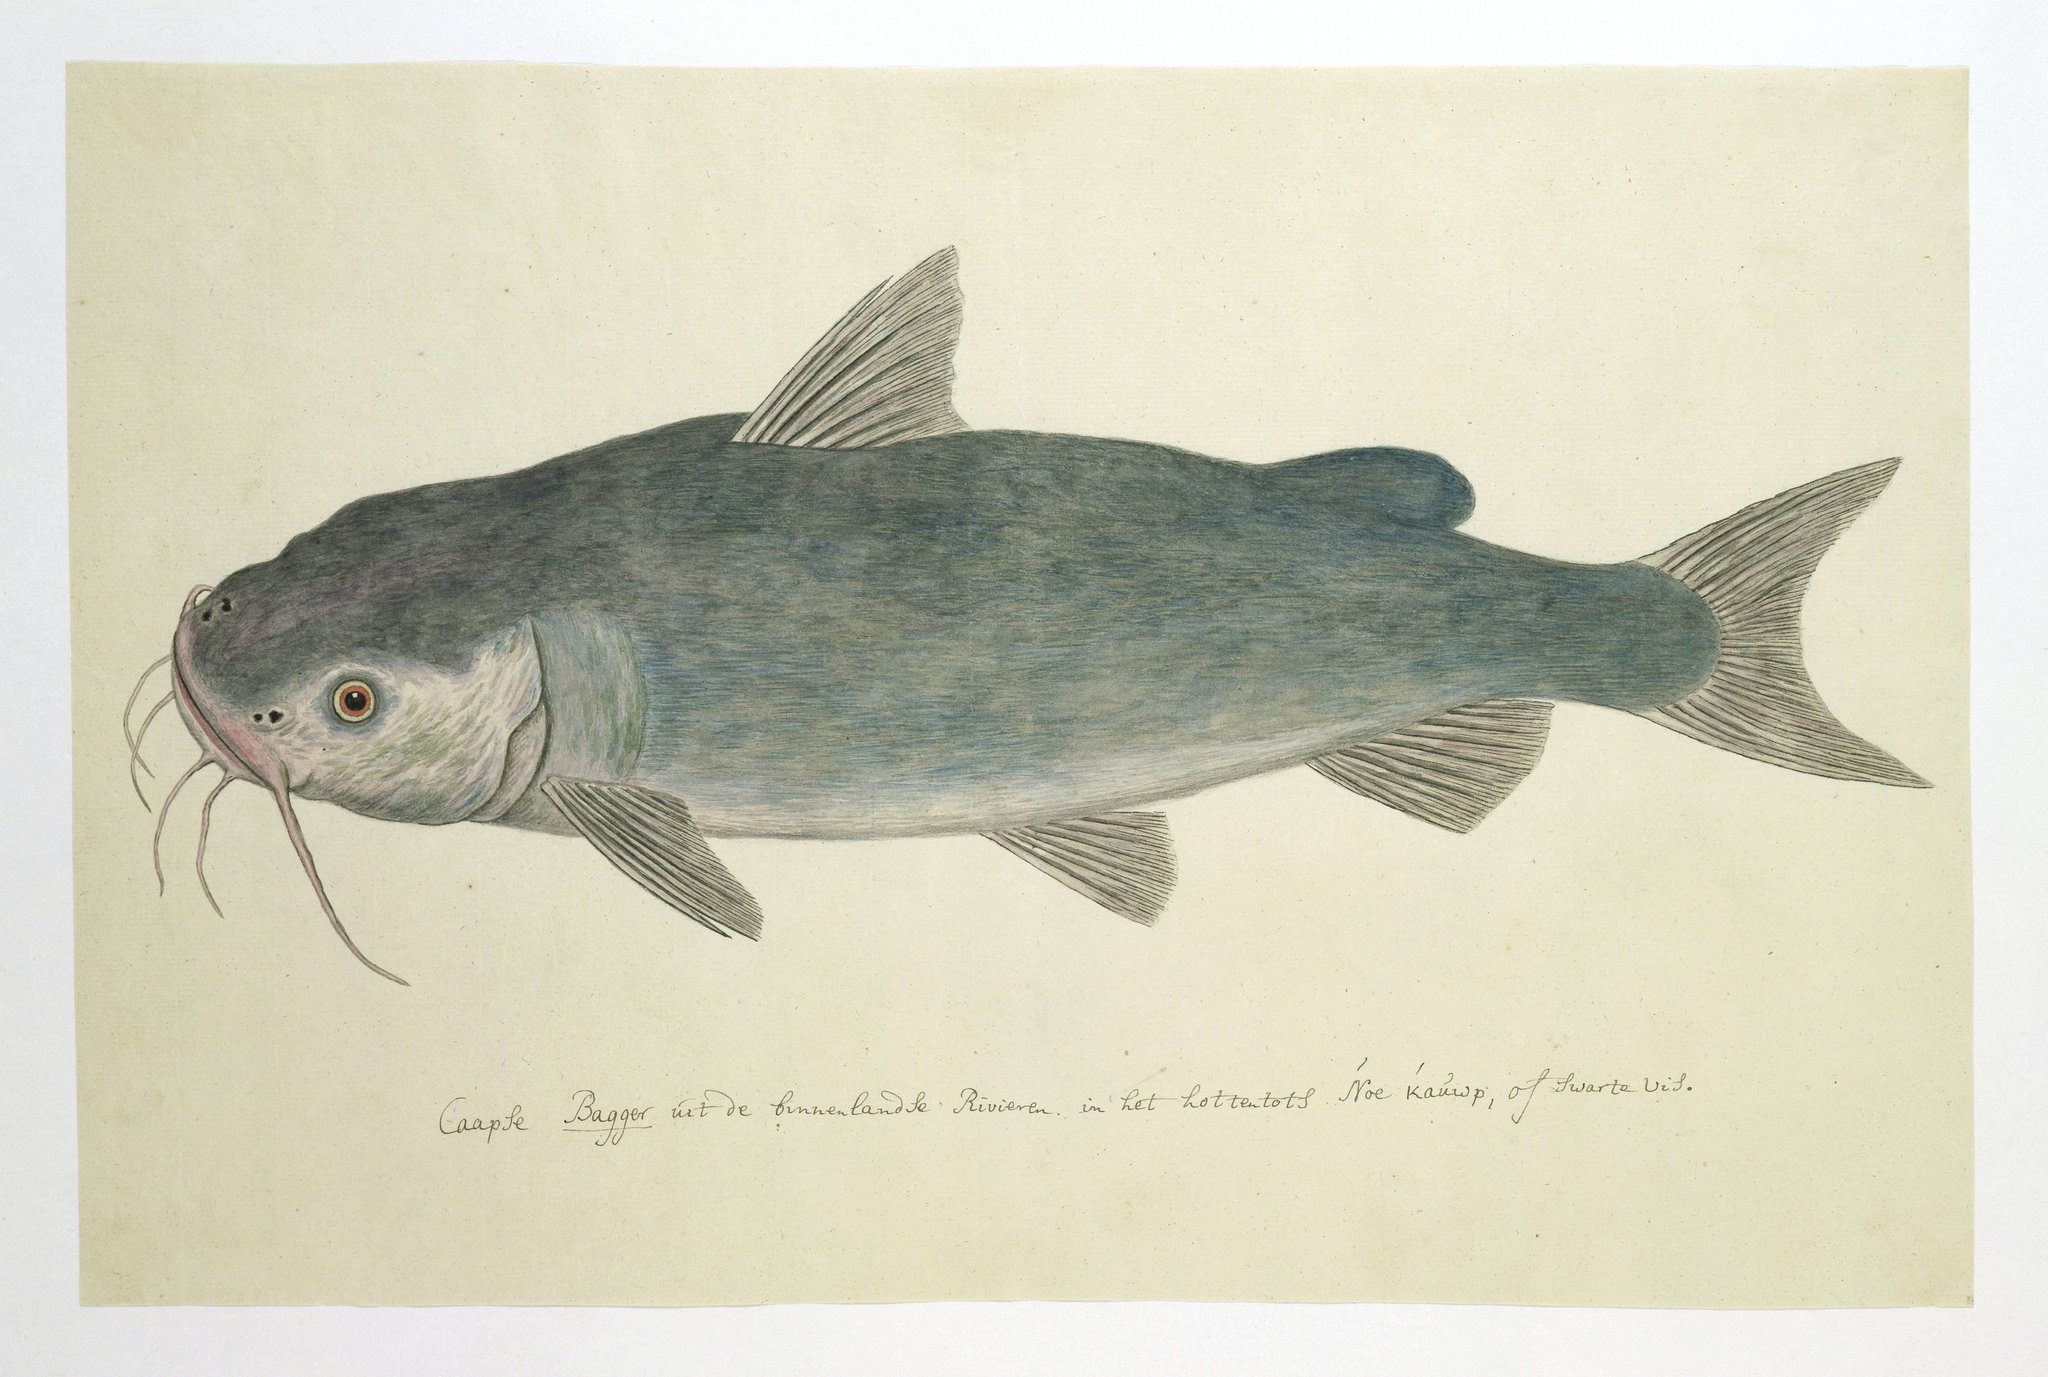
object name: album leaf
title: Clarias stappersii (catfish)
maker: robert jacob gordon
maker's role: draughtsman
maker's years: 1743-1795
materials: chalk, paper, pencil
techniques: brush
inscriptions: annotation: ‘Caapse Bagger [onderstreept] uit de binnenlandse Rivieren, in het hottentots 'Noe kaùwp, of Swarte Vis.’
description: Ongeïdentificeerd, komt voor in de rivieren in het binnenland.